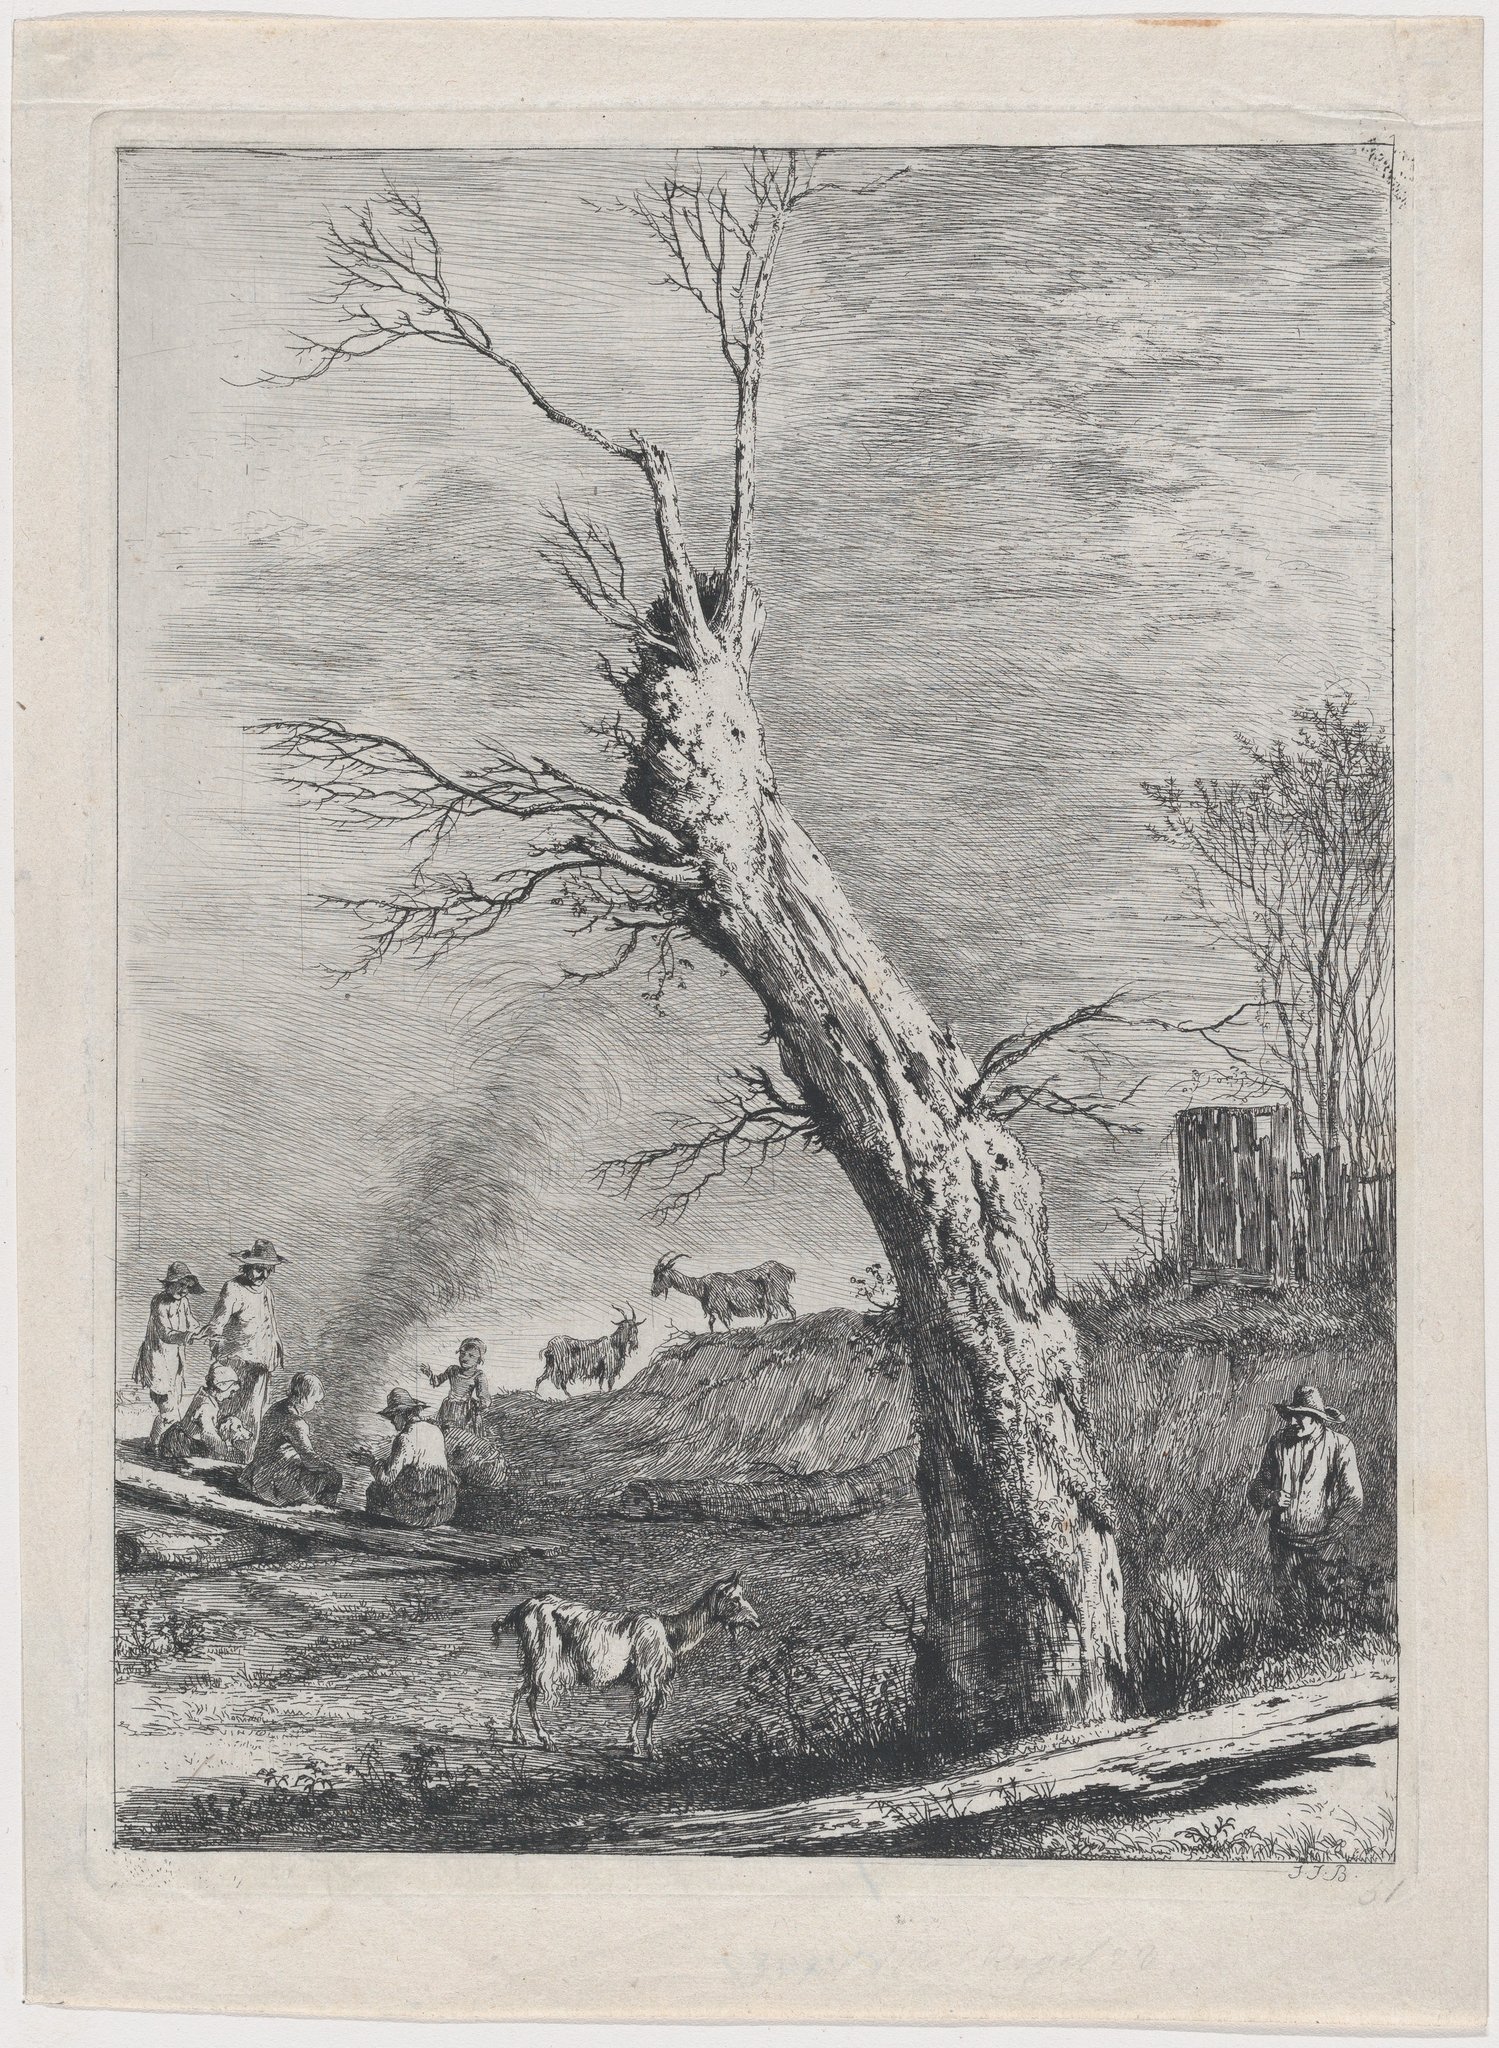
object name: print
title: Winter, after a drawing completed in Saint-Chamond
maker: jean jacques de boissieu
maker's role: artist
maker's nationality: french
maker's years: 1736-1810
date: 1795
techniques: drypoint, etching, roulette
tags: men,goats,trees,winter